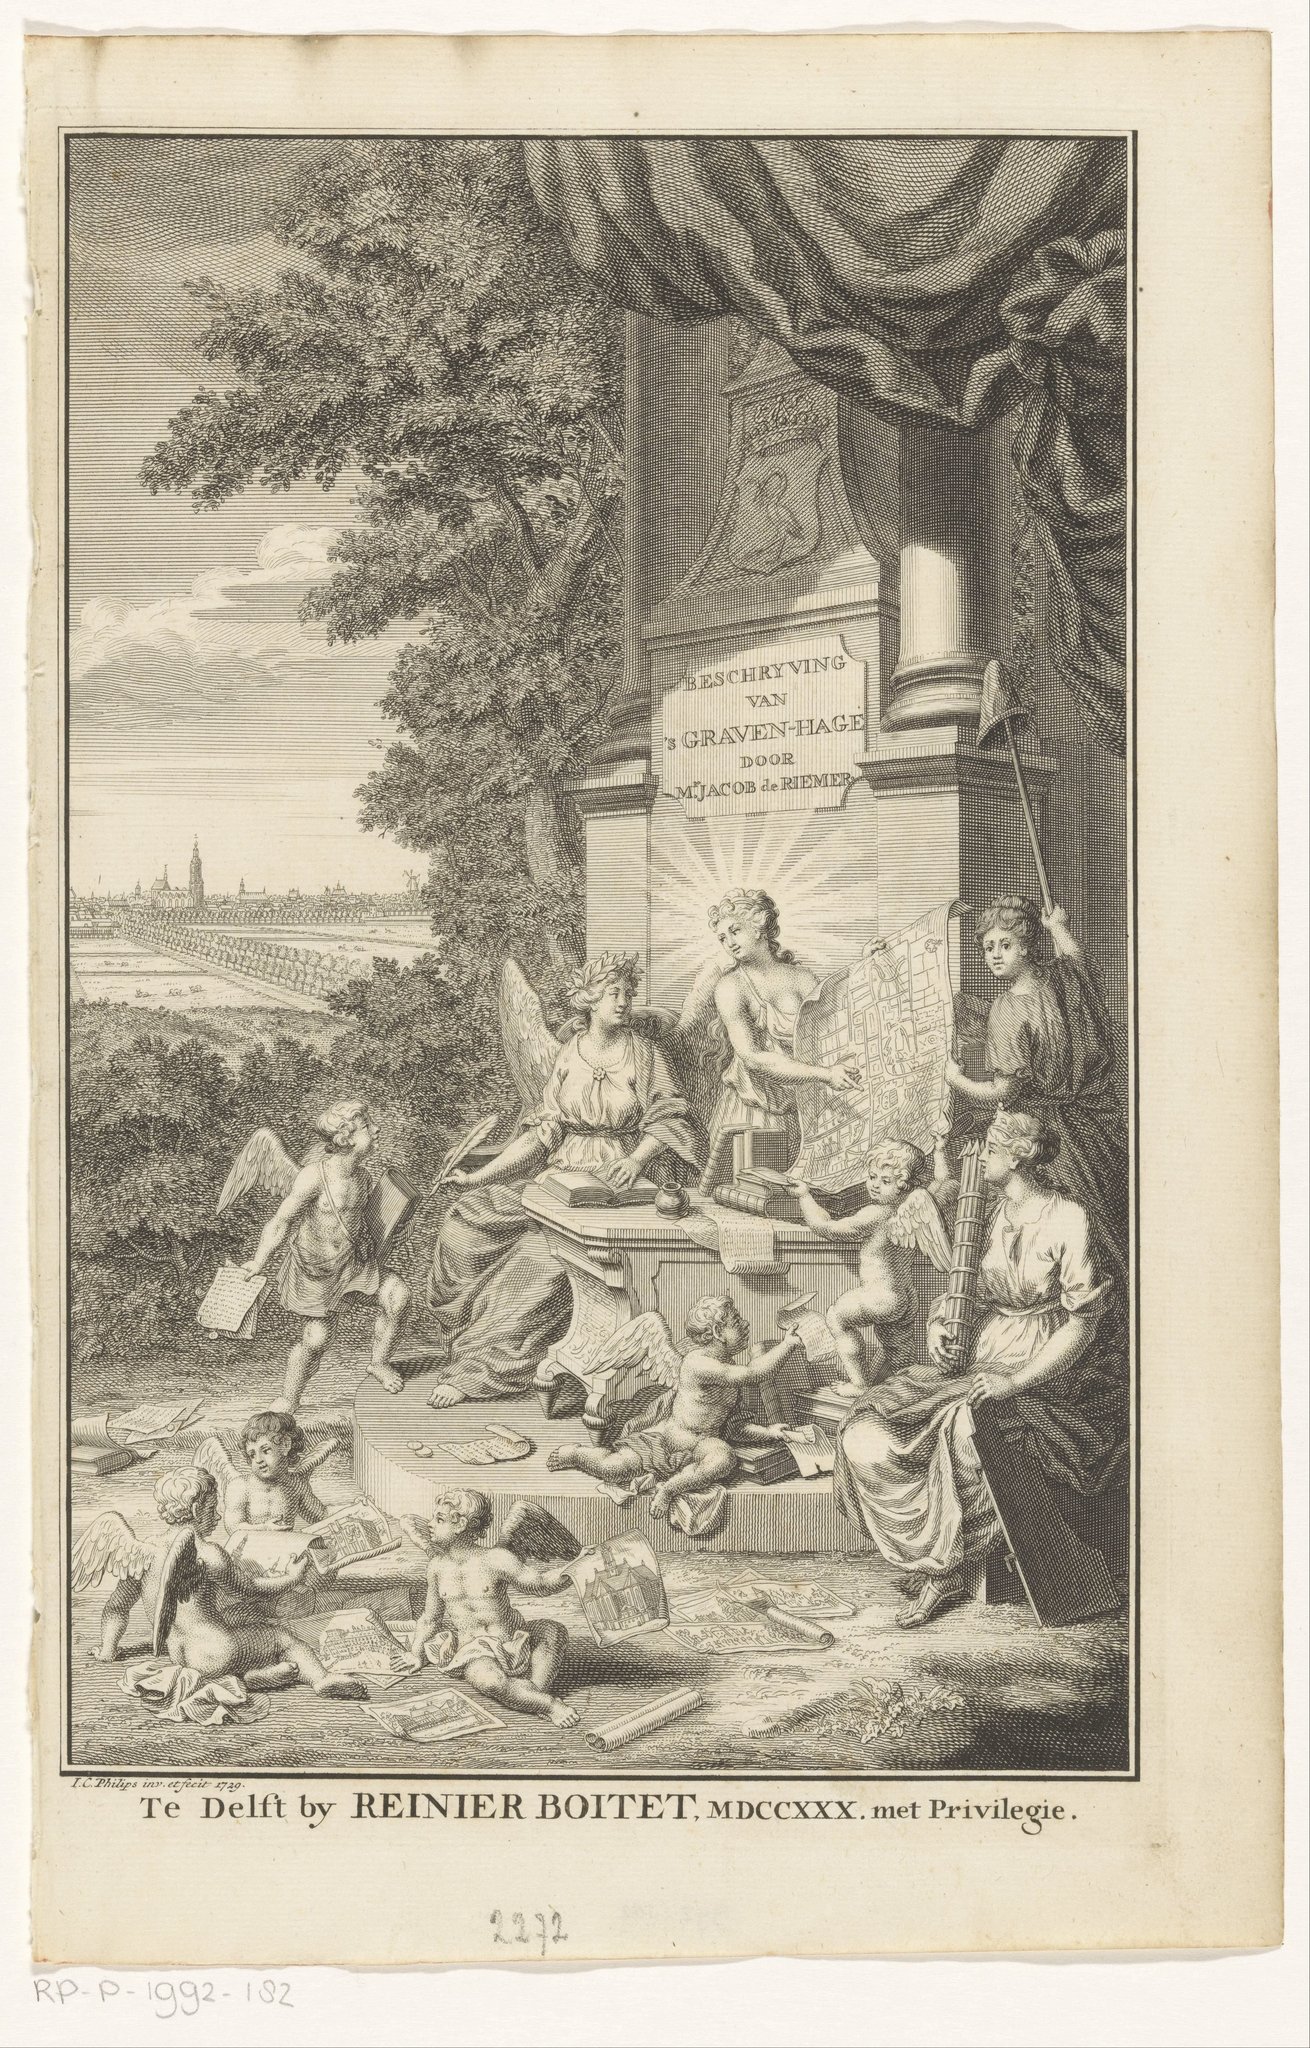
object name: titelblad, titelpagina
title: Titelpagina voor: Jacob de Riemer, Beschryving van 's Graven-Hage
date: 1729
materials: paper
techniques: engraving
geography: delft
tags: coat of arms (as symbol of the state, etc.), maps, atlases, landscape with monument, the hague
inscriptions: collector's mark: Lugt 2228, collector's mark: Lugt 2760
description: Op een monument in de vorm van een epitaaf een gedenksteen met boektitel. Daarboven het wapen van Den Haag. Voor het monument zit een groep van vier allegorische vrouwenfiguren rond de plattegrond van Den Haag. Om hen heen zes putti met boeken en prenten over de stad. Op de achtergrond het profiel van Den Haag.